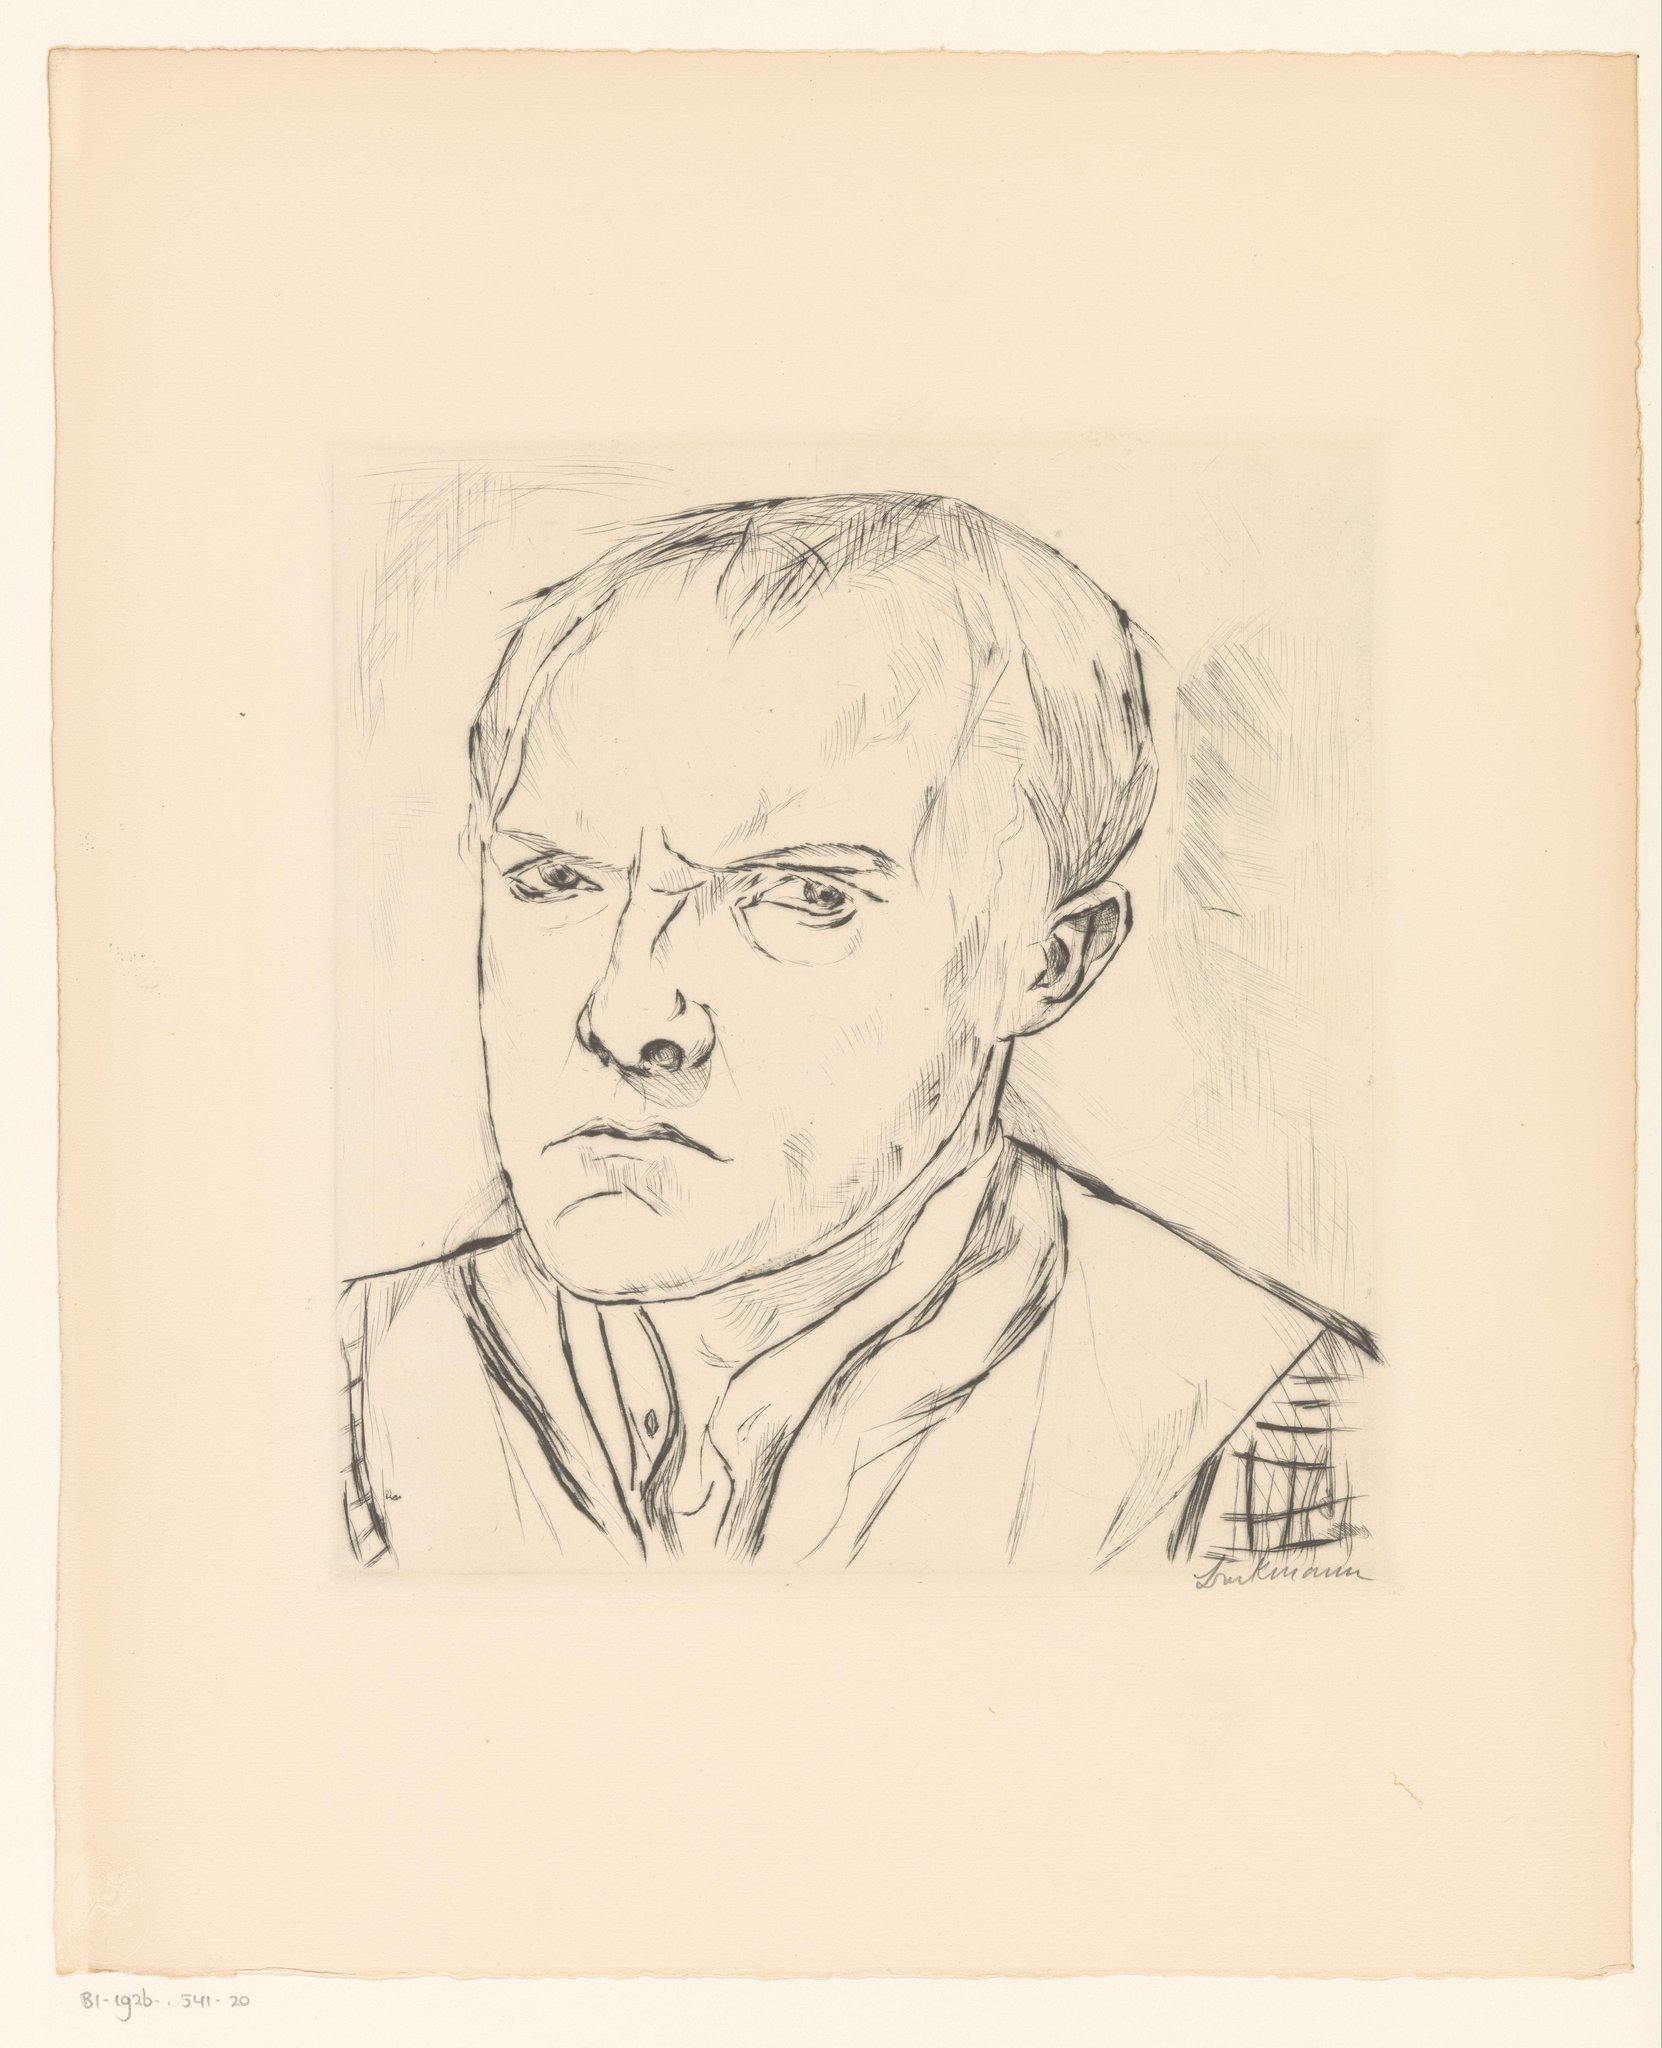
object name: print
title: Gesichten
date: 1918-1919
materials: paper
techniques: drypoint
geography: munich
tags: new york (city), print maker, max beckmann, portrait, self-portrait of graphic artist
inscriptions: collector's mark: Lugt 5629, collector's mark: Lugt 2166